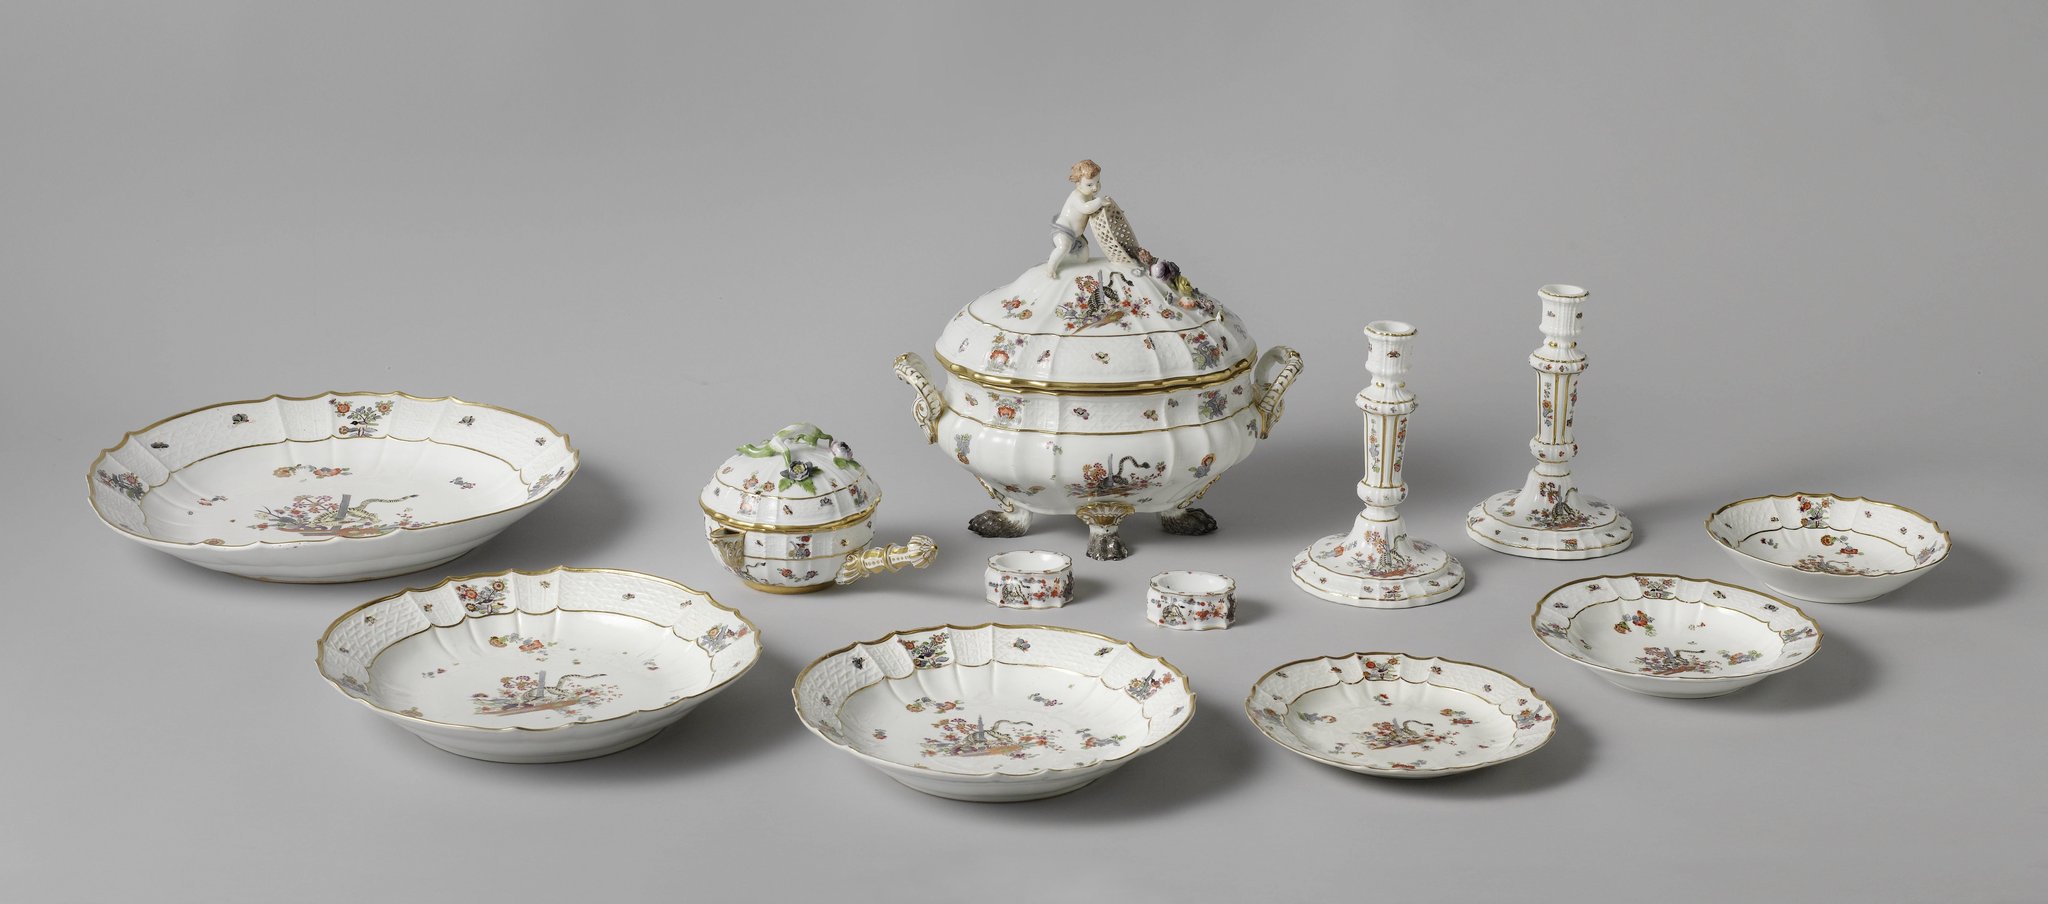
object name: service set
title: 175 delen van een servies, veelkleurig beschilderd met een Kakiemon-decor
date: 1740-1745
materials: porcelain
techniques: painted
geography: meissen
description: 175 delen van een servies, veelkleurig beschilderd met een Kakiemon-decor, bestaande uit 6 kandelaars, twee zoutvaten, 1 grote ovale terrine, 2 kleine ovale terrines, 3 ronde terrines met handvat, 43 schalen (in zes maten), 26 soepborden en 92 borden.